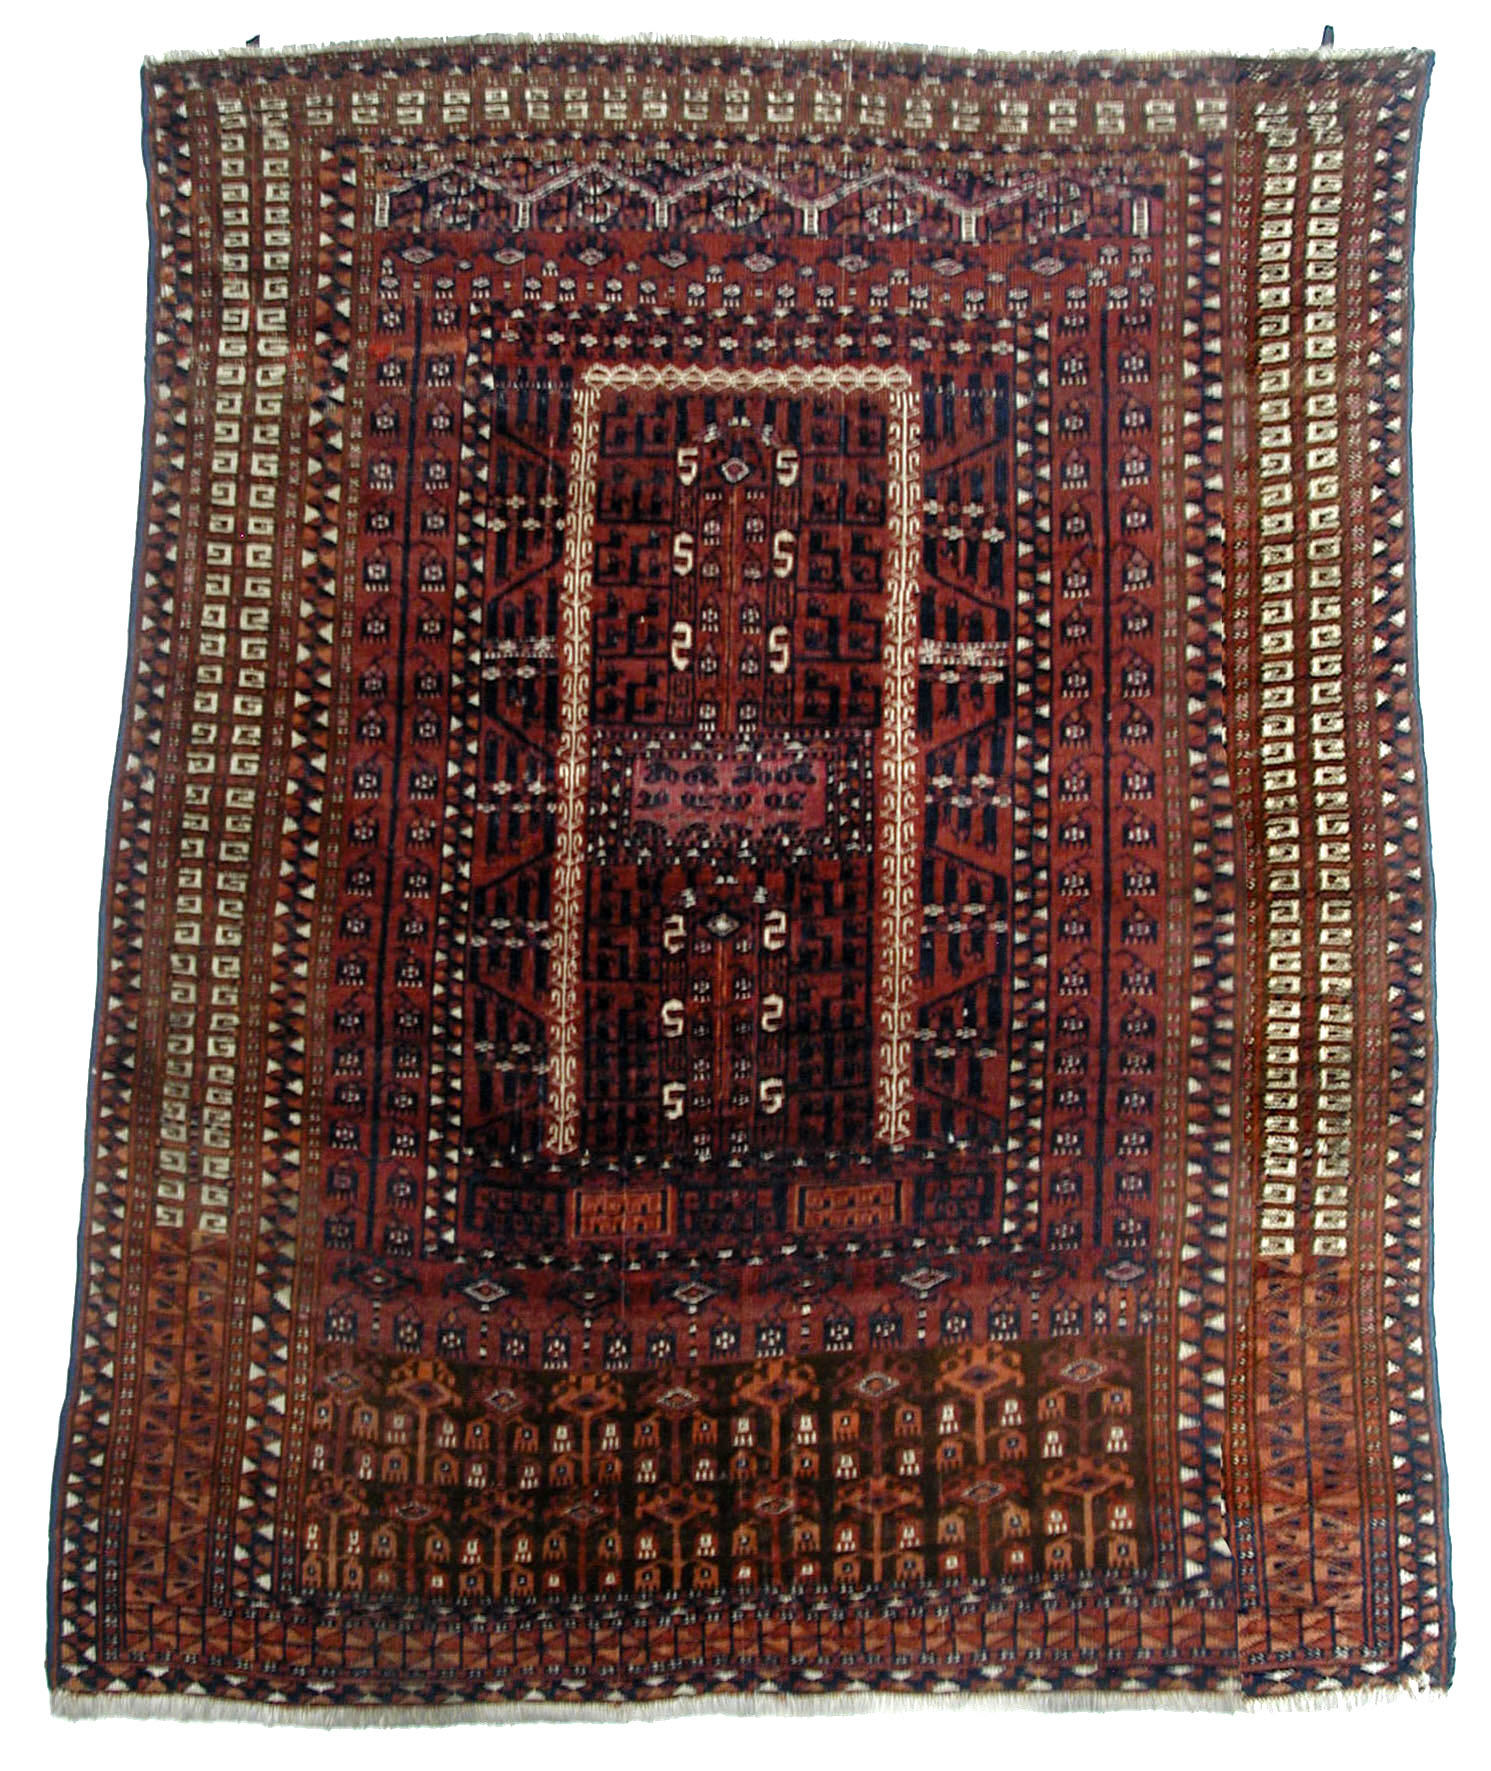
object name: tent door hanging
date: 1801-1850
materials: cotton, wool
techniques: pile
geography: afghanistan or turkmenistan